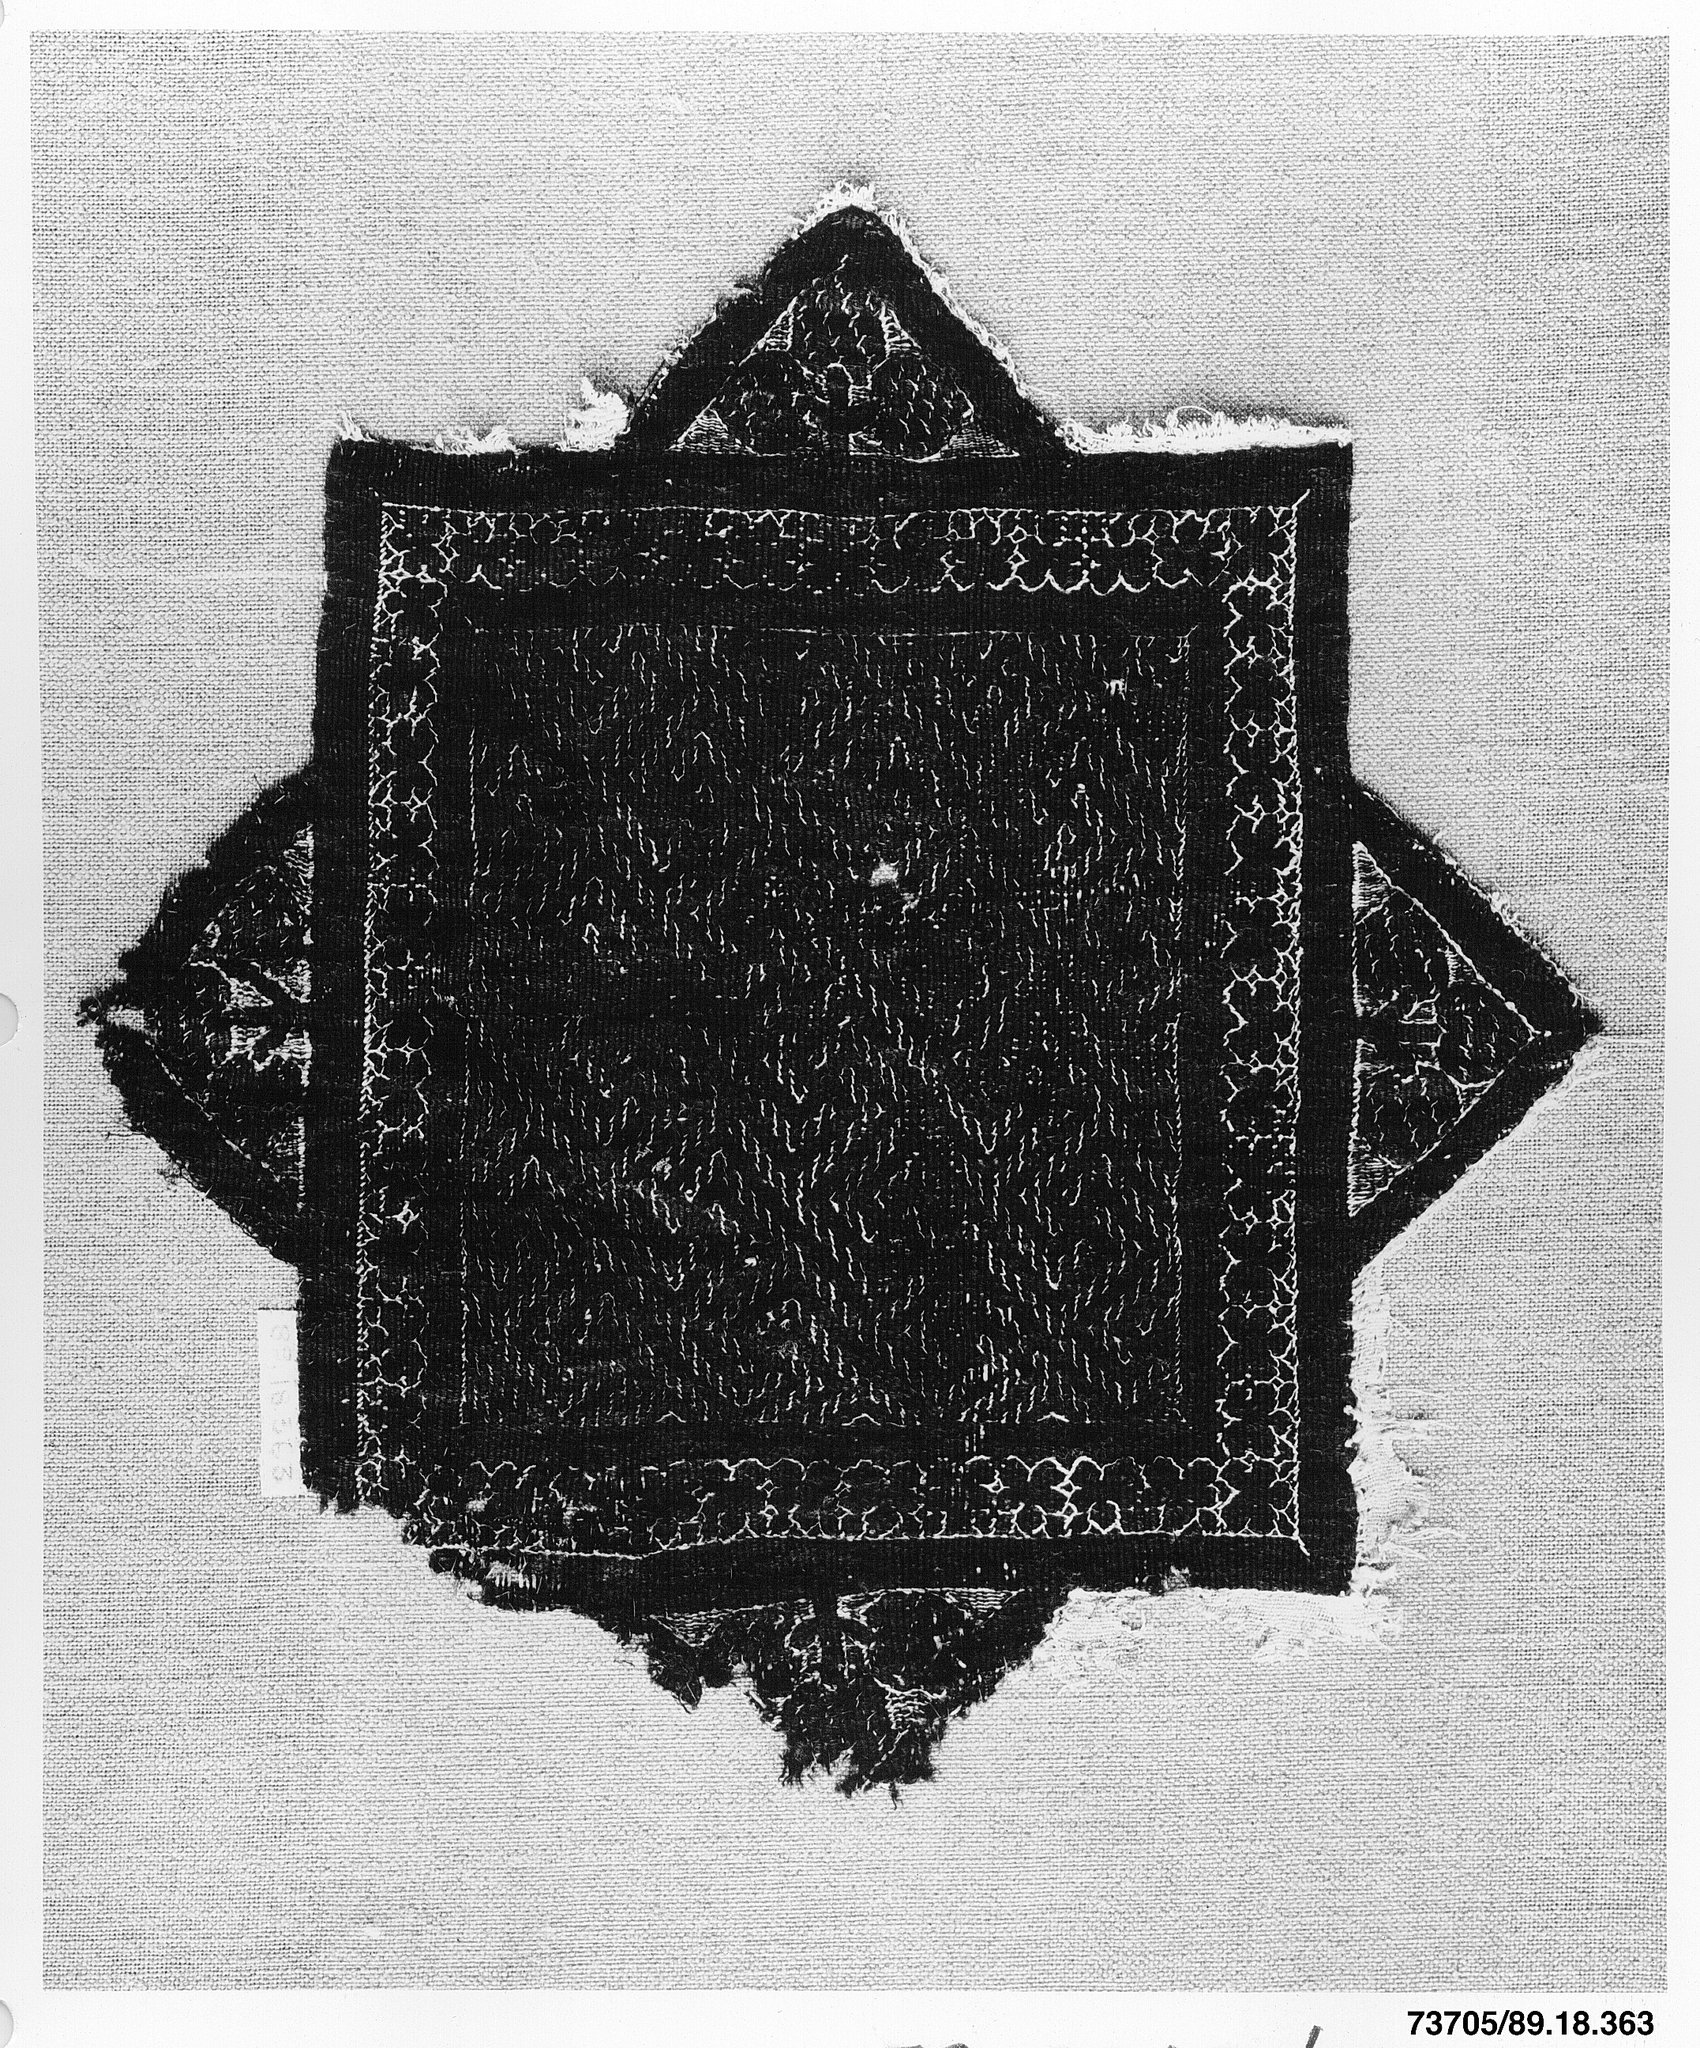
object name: textile fragment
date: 201-400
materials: linen, wool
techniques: weave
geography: egypt